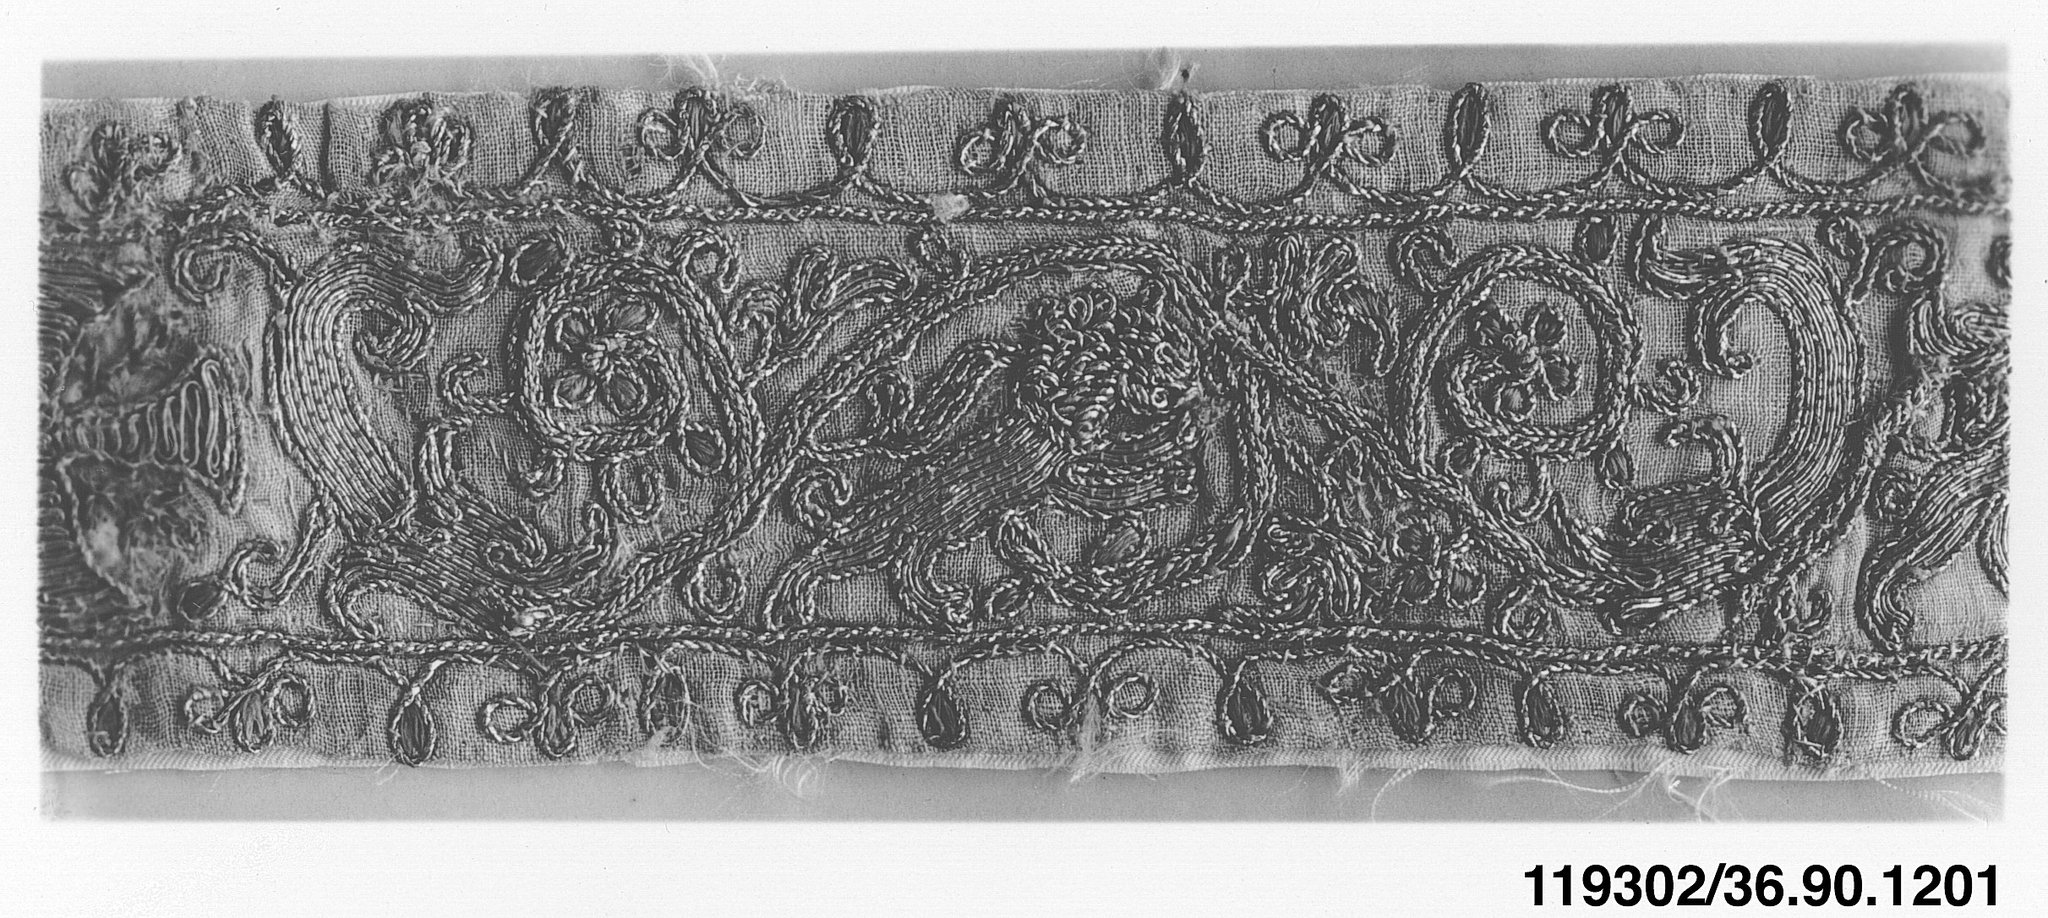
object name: band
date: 1501-1600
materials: linen, metal thread, silk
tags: animals